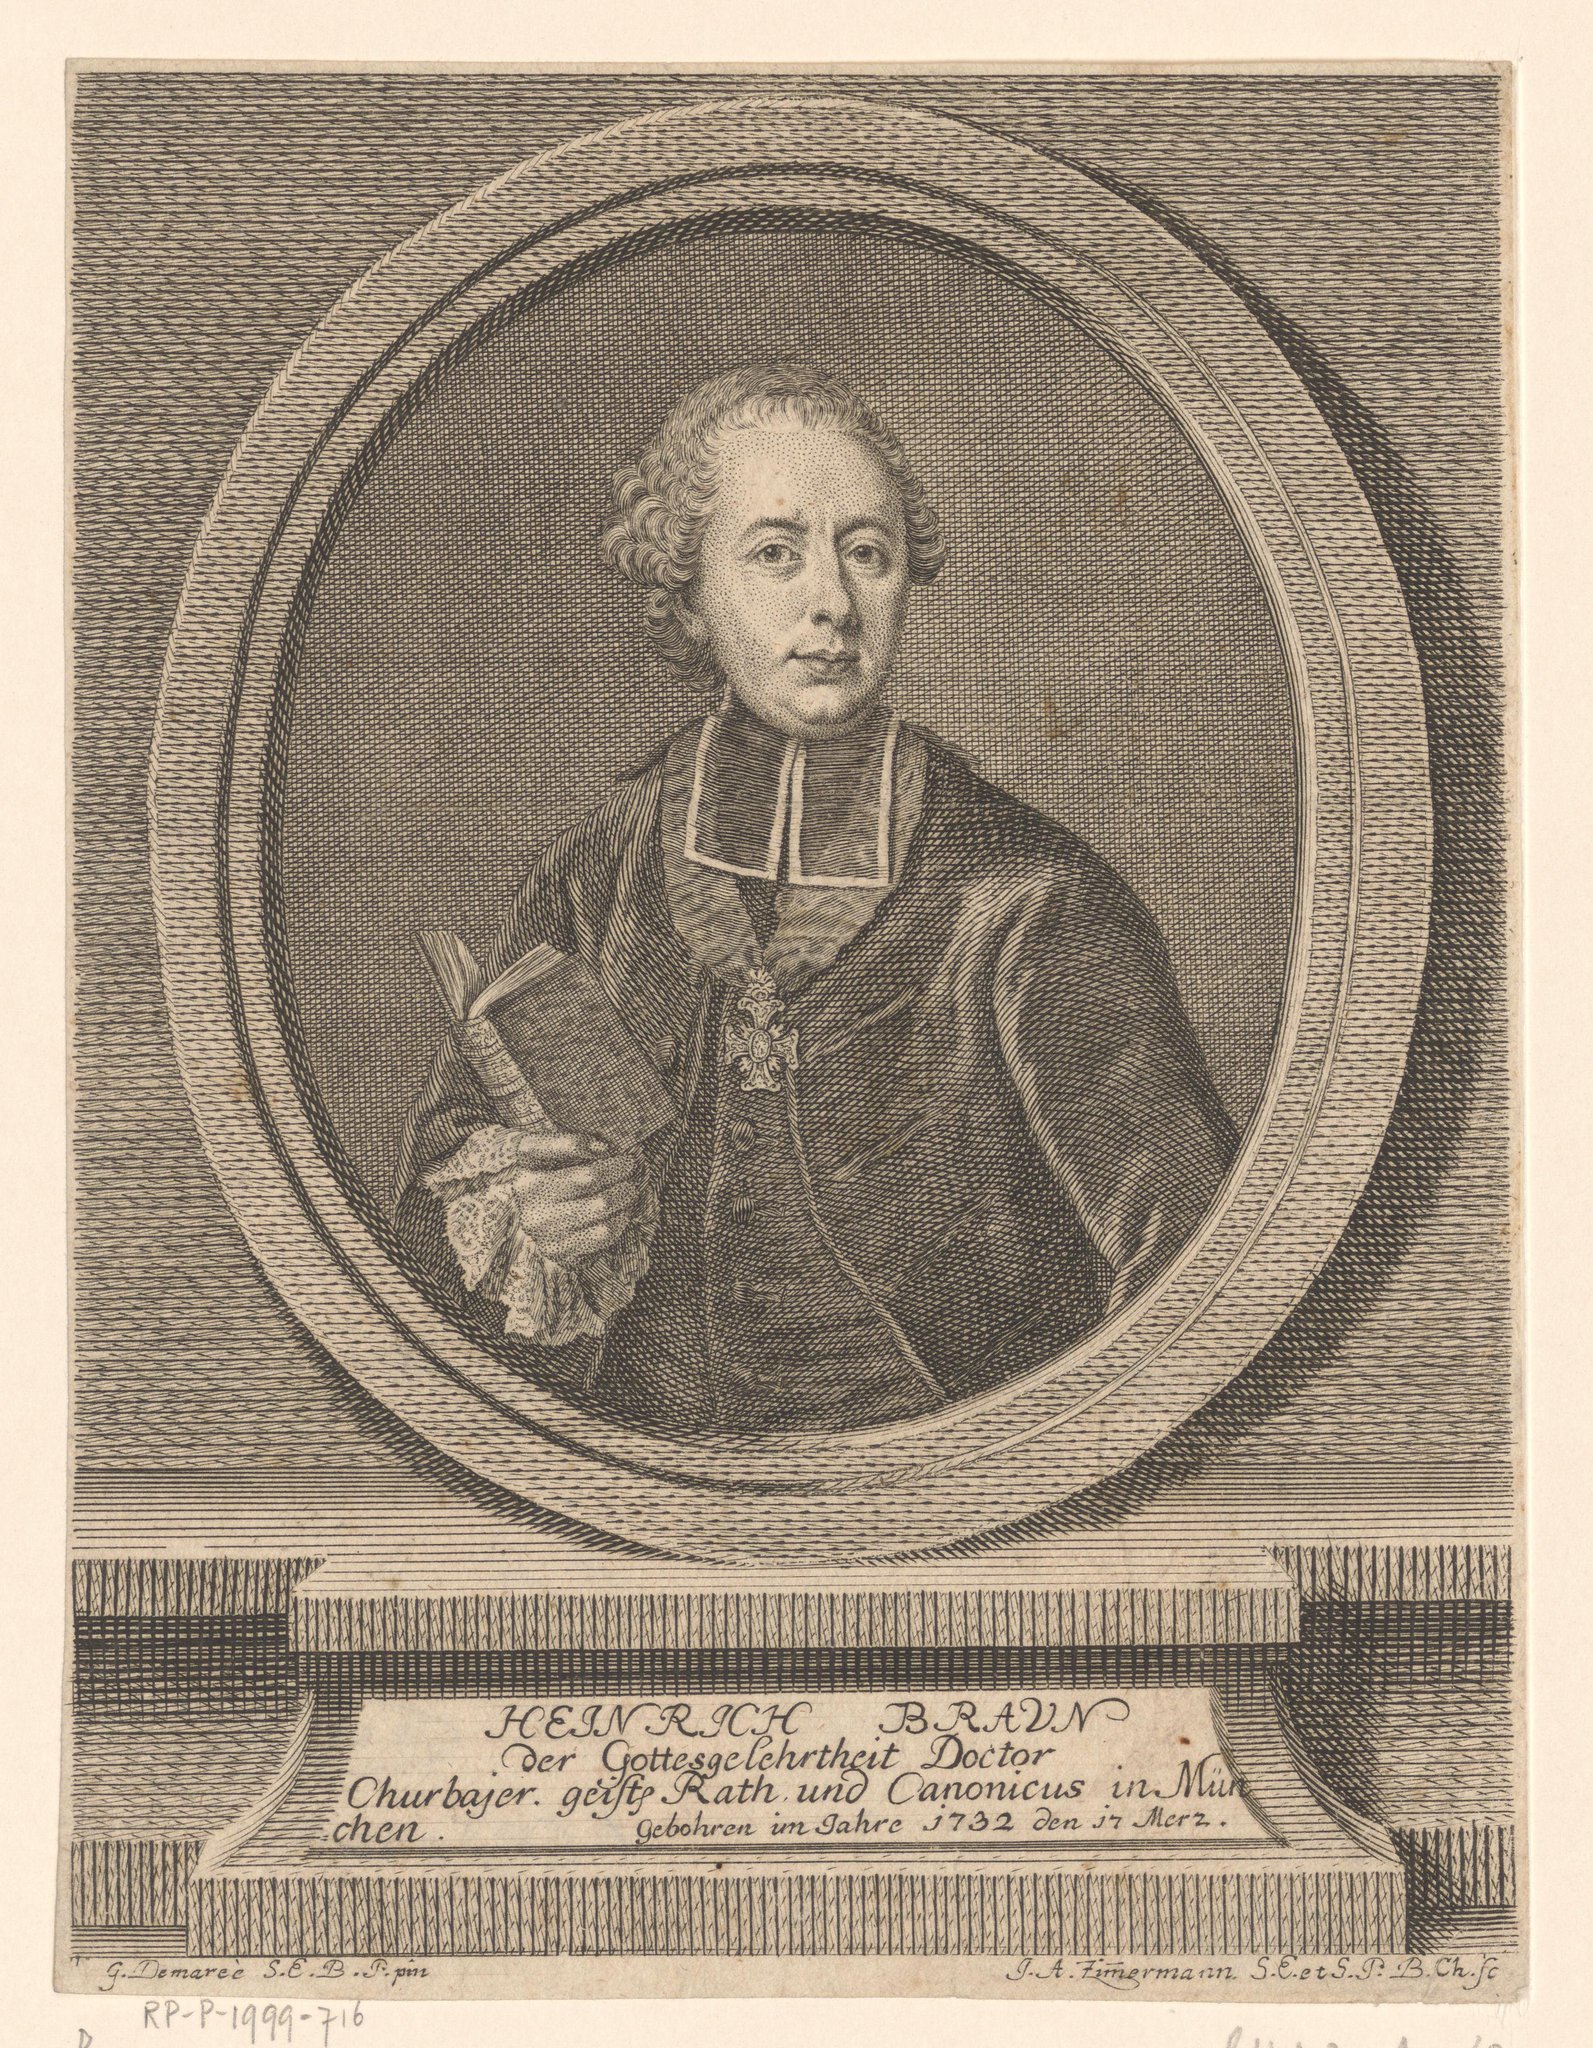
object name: print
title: Portret van Heinrich Braun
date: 1732-1797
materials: paper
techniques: engraving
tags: theologian, historical persons, book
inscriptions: collector's mark: Lugt 1614, collector's mark: Lugt 2228, collector's mark: Lugt 2397